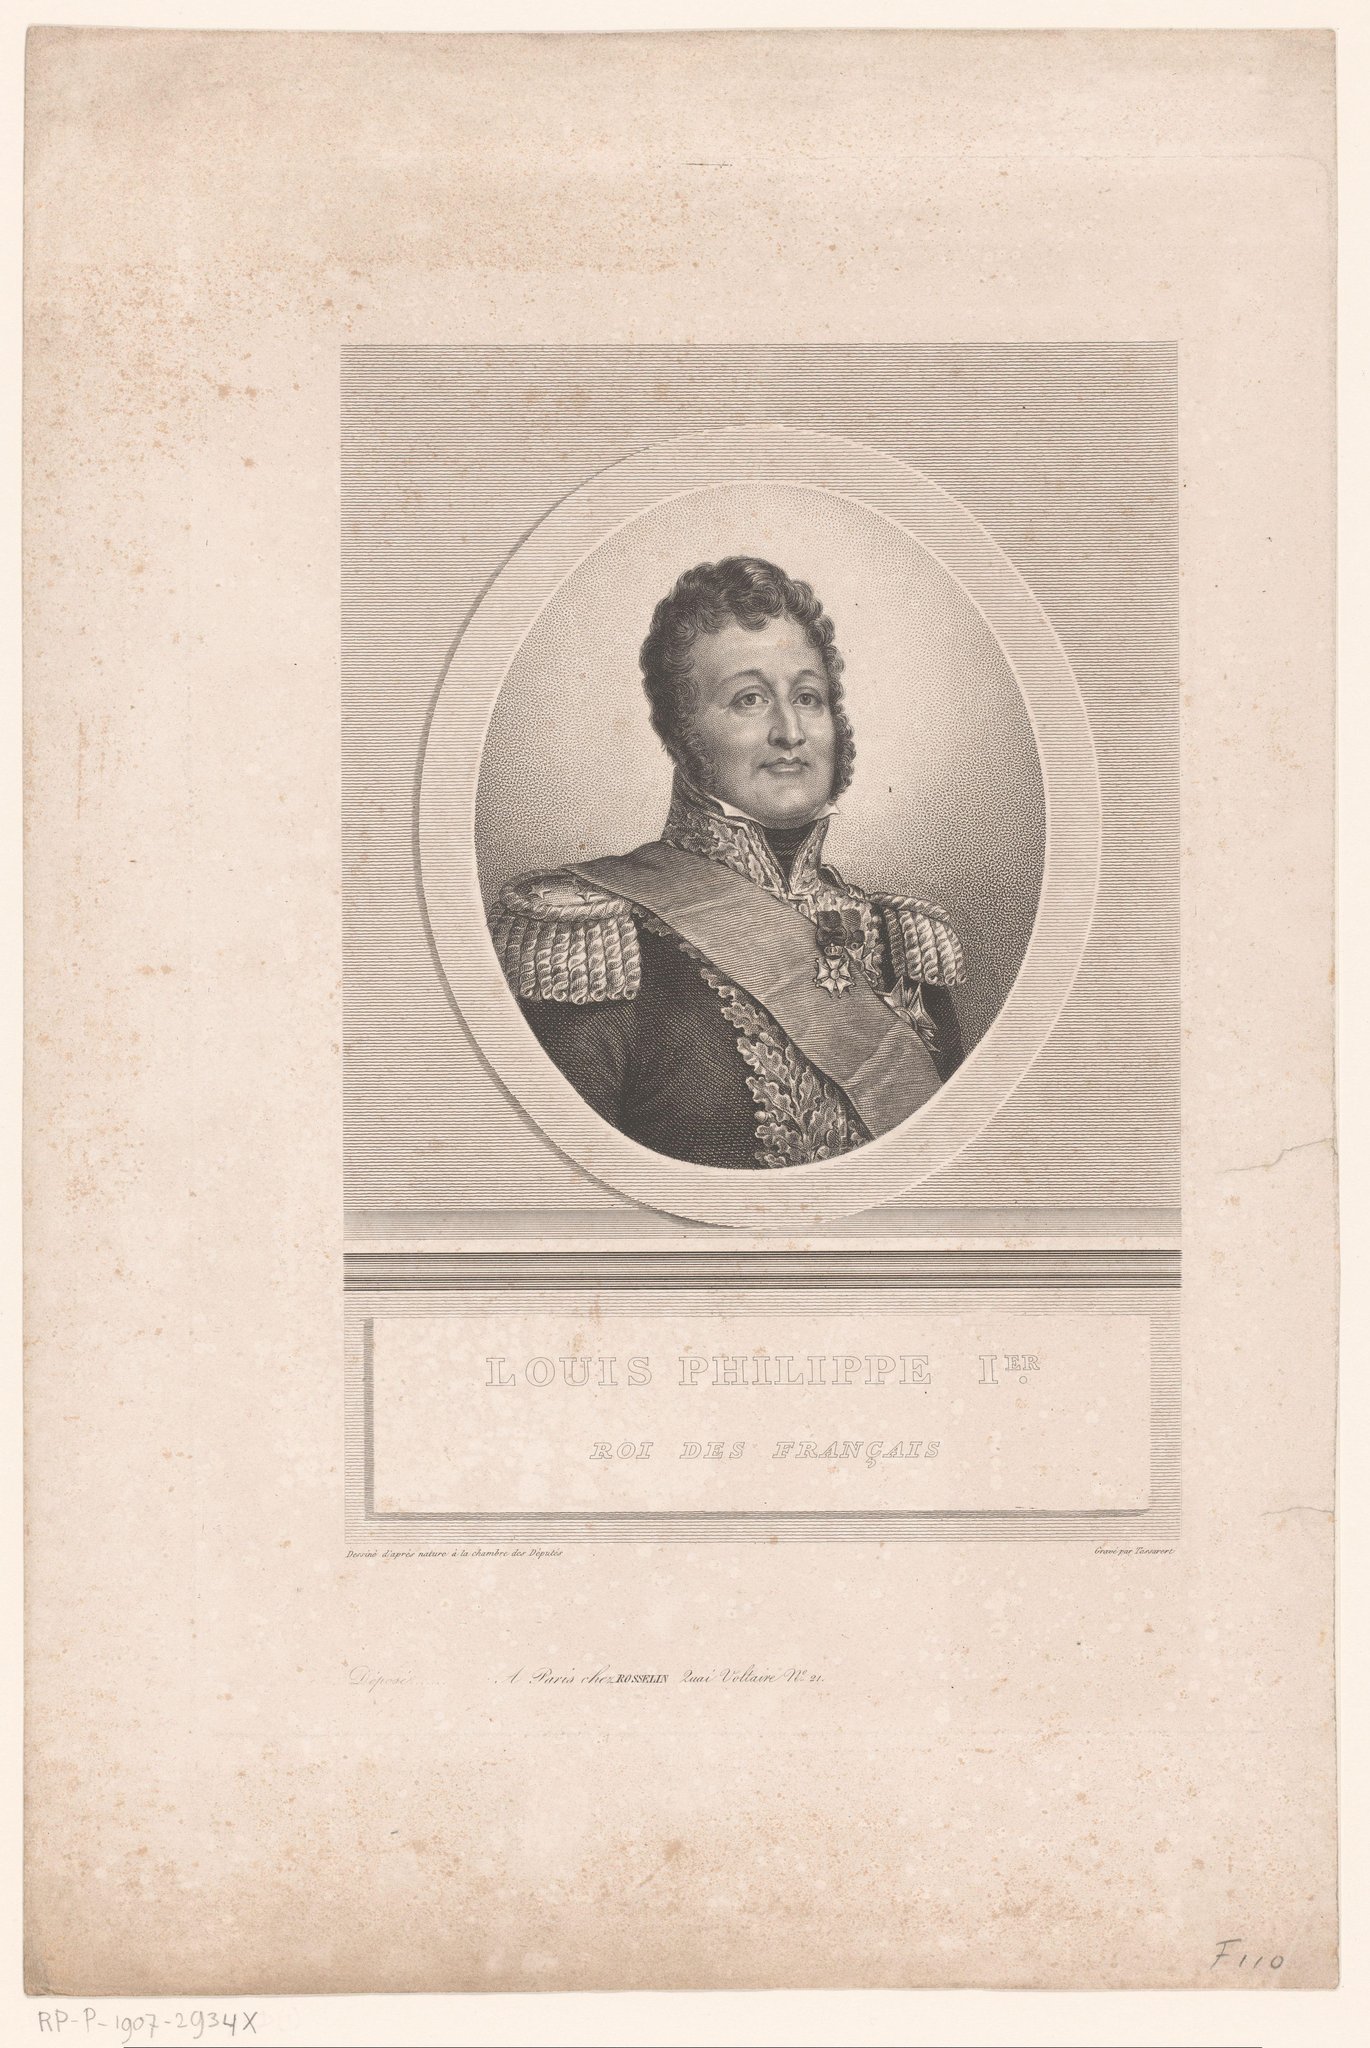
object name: print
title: Portret van koning Lodewijk Filips I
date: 1810-1874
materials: paper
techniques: drypoint, etching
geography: paris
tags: paris, lodewijk filips i (koning van frankrijk), historical persons, king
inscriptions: collector's mark: Lugt 2228